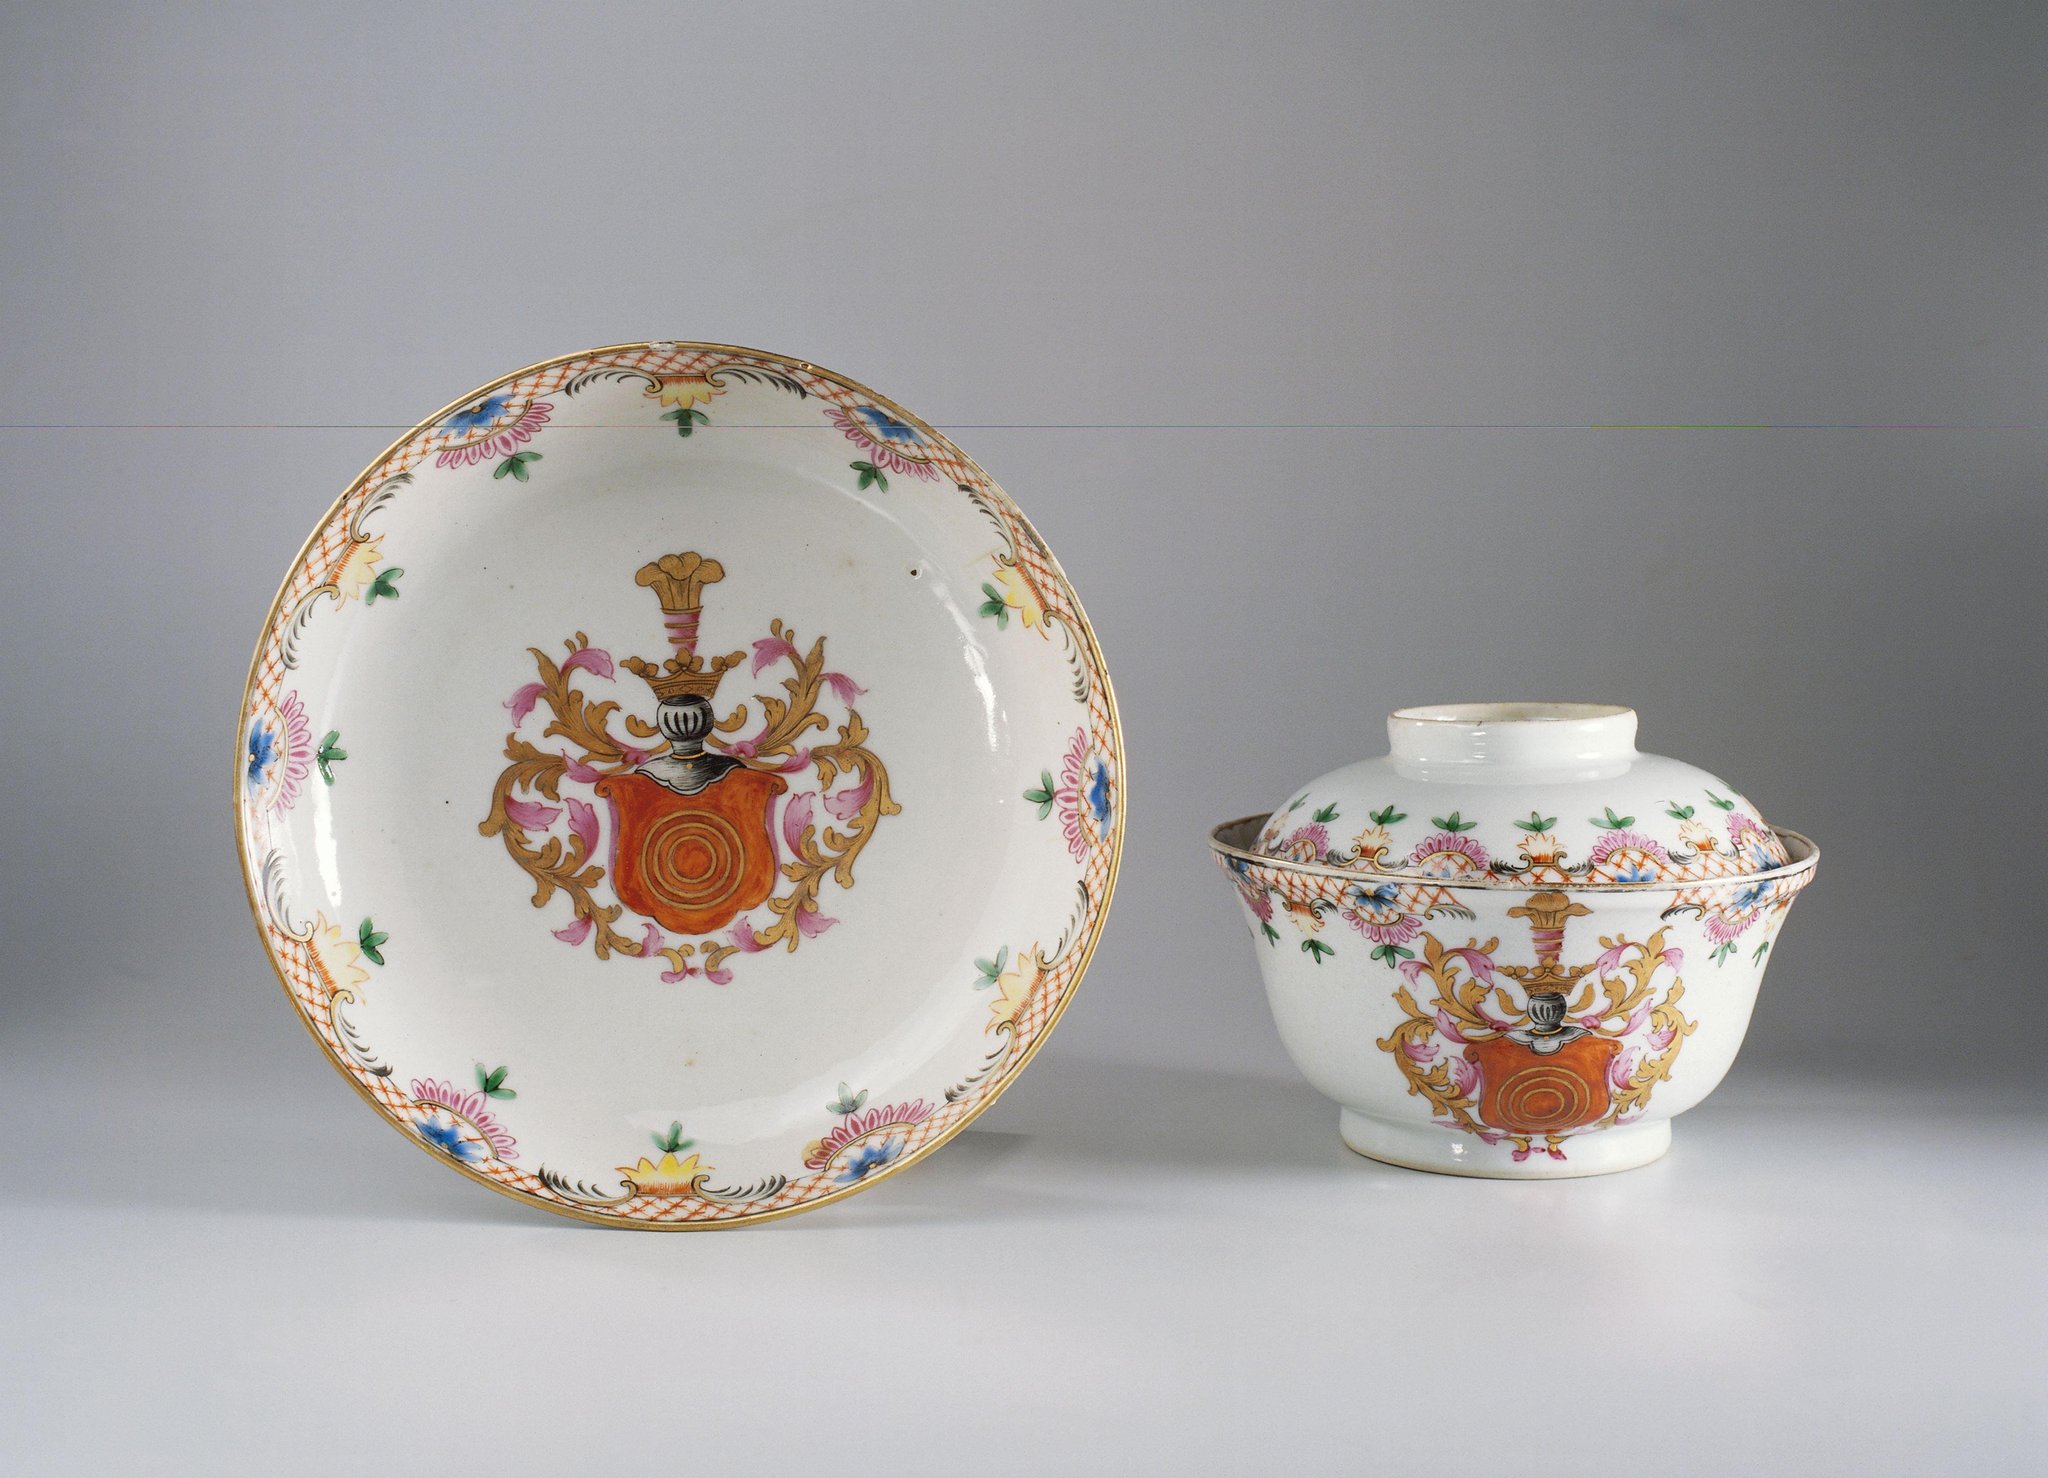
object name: platter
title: Saucer with the arms of the Romswinckel family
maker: Anonymous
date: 1765-1770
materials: glaze, gold, paint, porcelain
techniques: firing, gilding, turning, vitrification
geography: china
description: Schotel van porselein, beschilderd op het glazuur in blauw, rood, roze, groen, geel, zwart en goud. Op het plat van de schotel het wapen van de familie Romswinckel. Het wapen heeft een rode achtergrond met drie concentrische gouden ringen. Het helmteken is een kroon met daarboven drie ringen en pluimen. Het dekkleed bestaat uit bladranken. Op de binnenrand een decoratieve band met traliewerk en bladranken met gestileerde bloemen. Twee barsten in de wand van de schotel. Wapenporselein met emailkleuren.